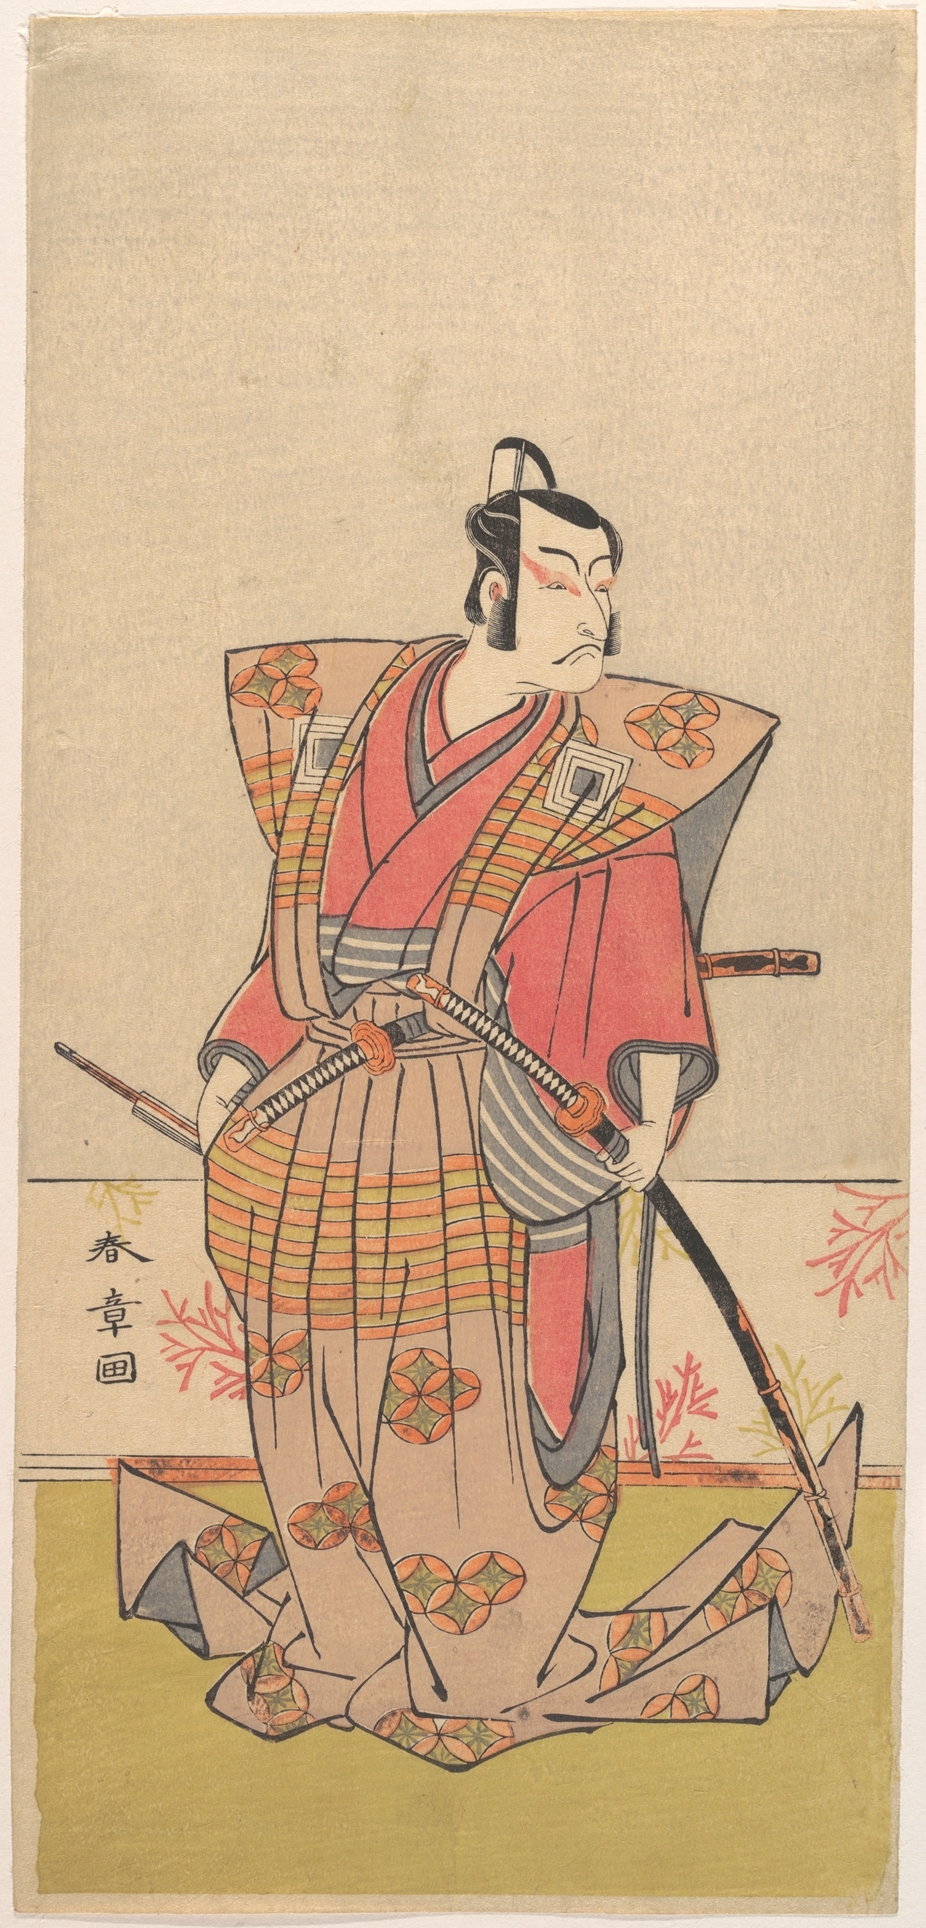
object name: woodblock print nishiki e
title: The Actor Ichikawa Danjūrō V as a Samurai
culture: japanese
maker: katsukawa shunshō 勝川春章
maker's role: artist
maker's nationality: japanese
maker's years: 1726-1792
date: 1771-1772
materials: ink, paper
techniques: nishiki e, woodblock print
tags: swords,men,actors